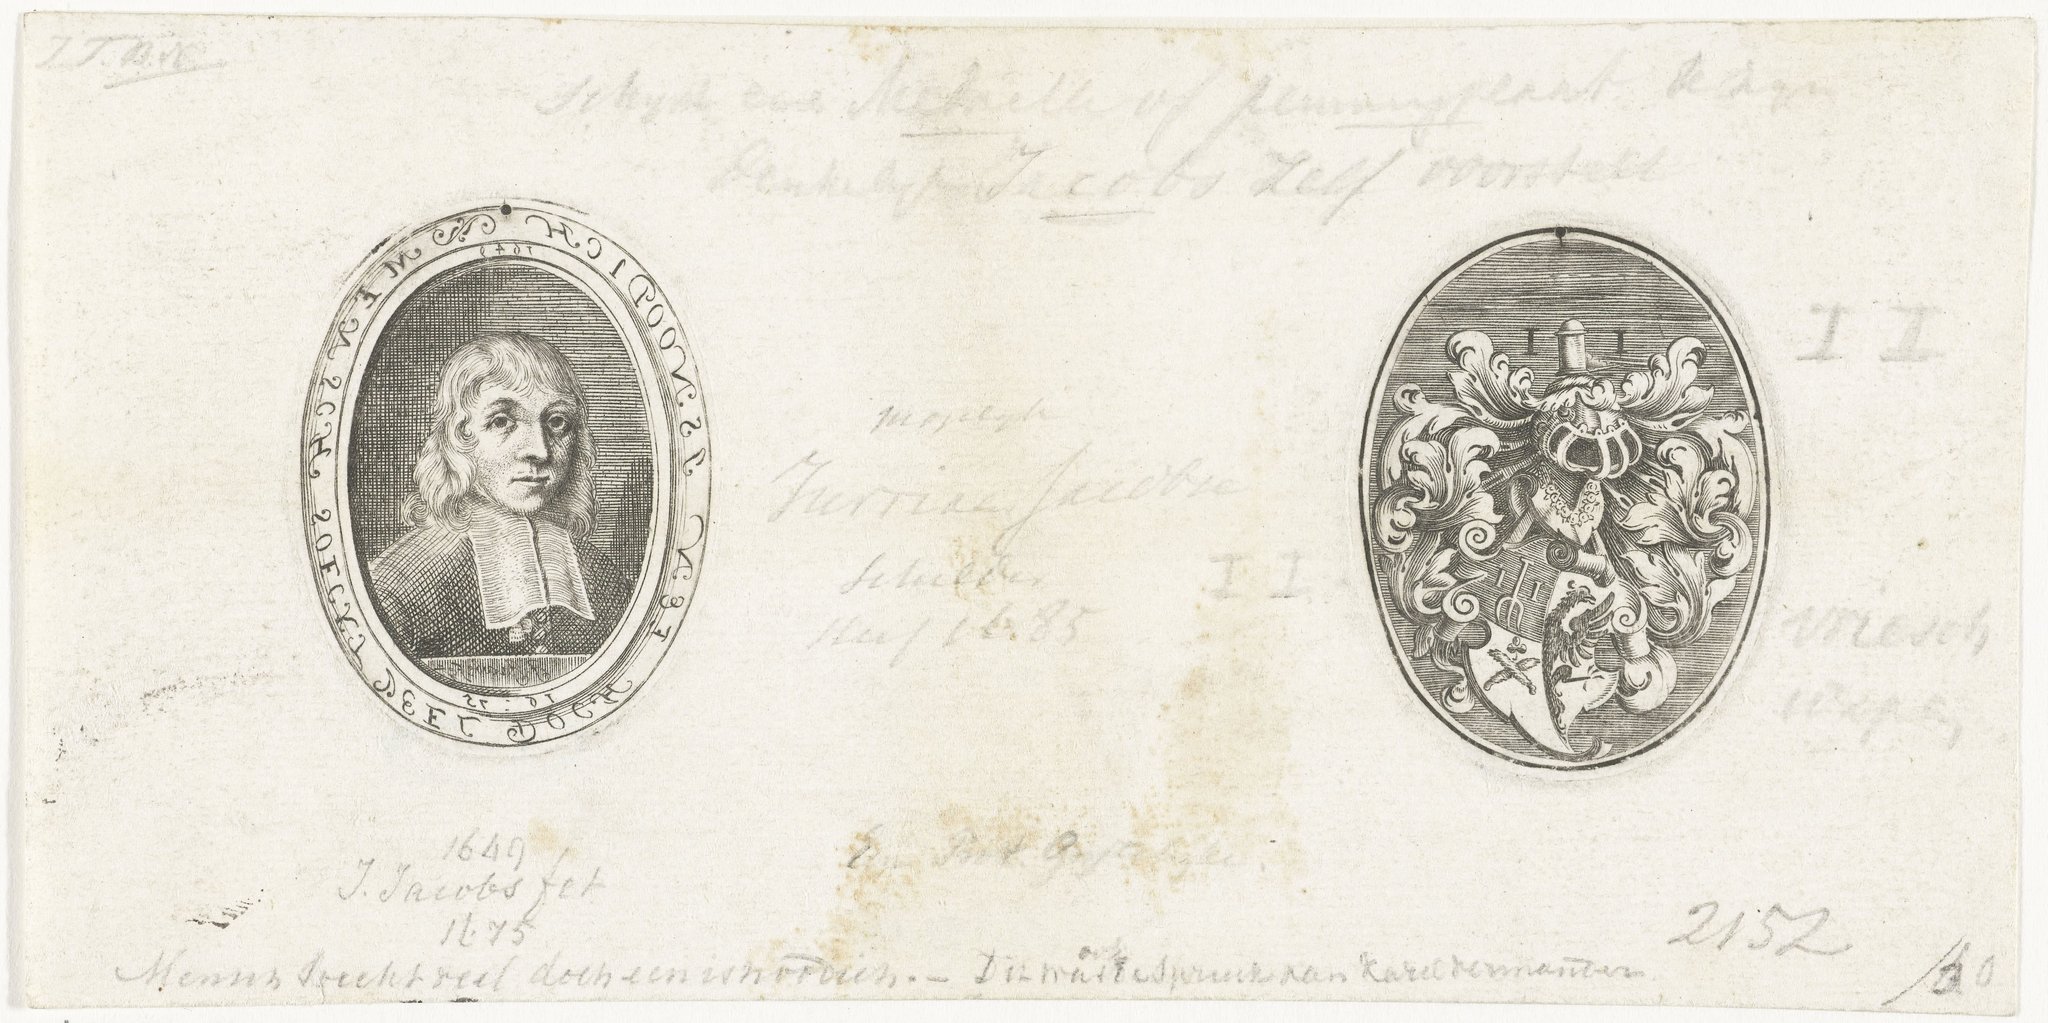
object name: print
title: Zelfportret van Jan Jacobsz Folkema naast zijn familiewapen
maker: johannes jacobsz folkema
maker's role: print maker, silversmith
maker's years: 1649-1735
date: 1675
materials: paper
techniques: engraving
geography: bolsward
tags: print maker, silversmith, johannes jacobsz folkema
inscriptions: collector's mark: Lugt 2228